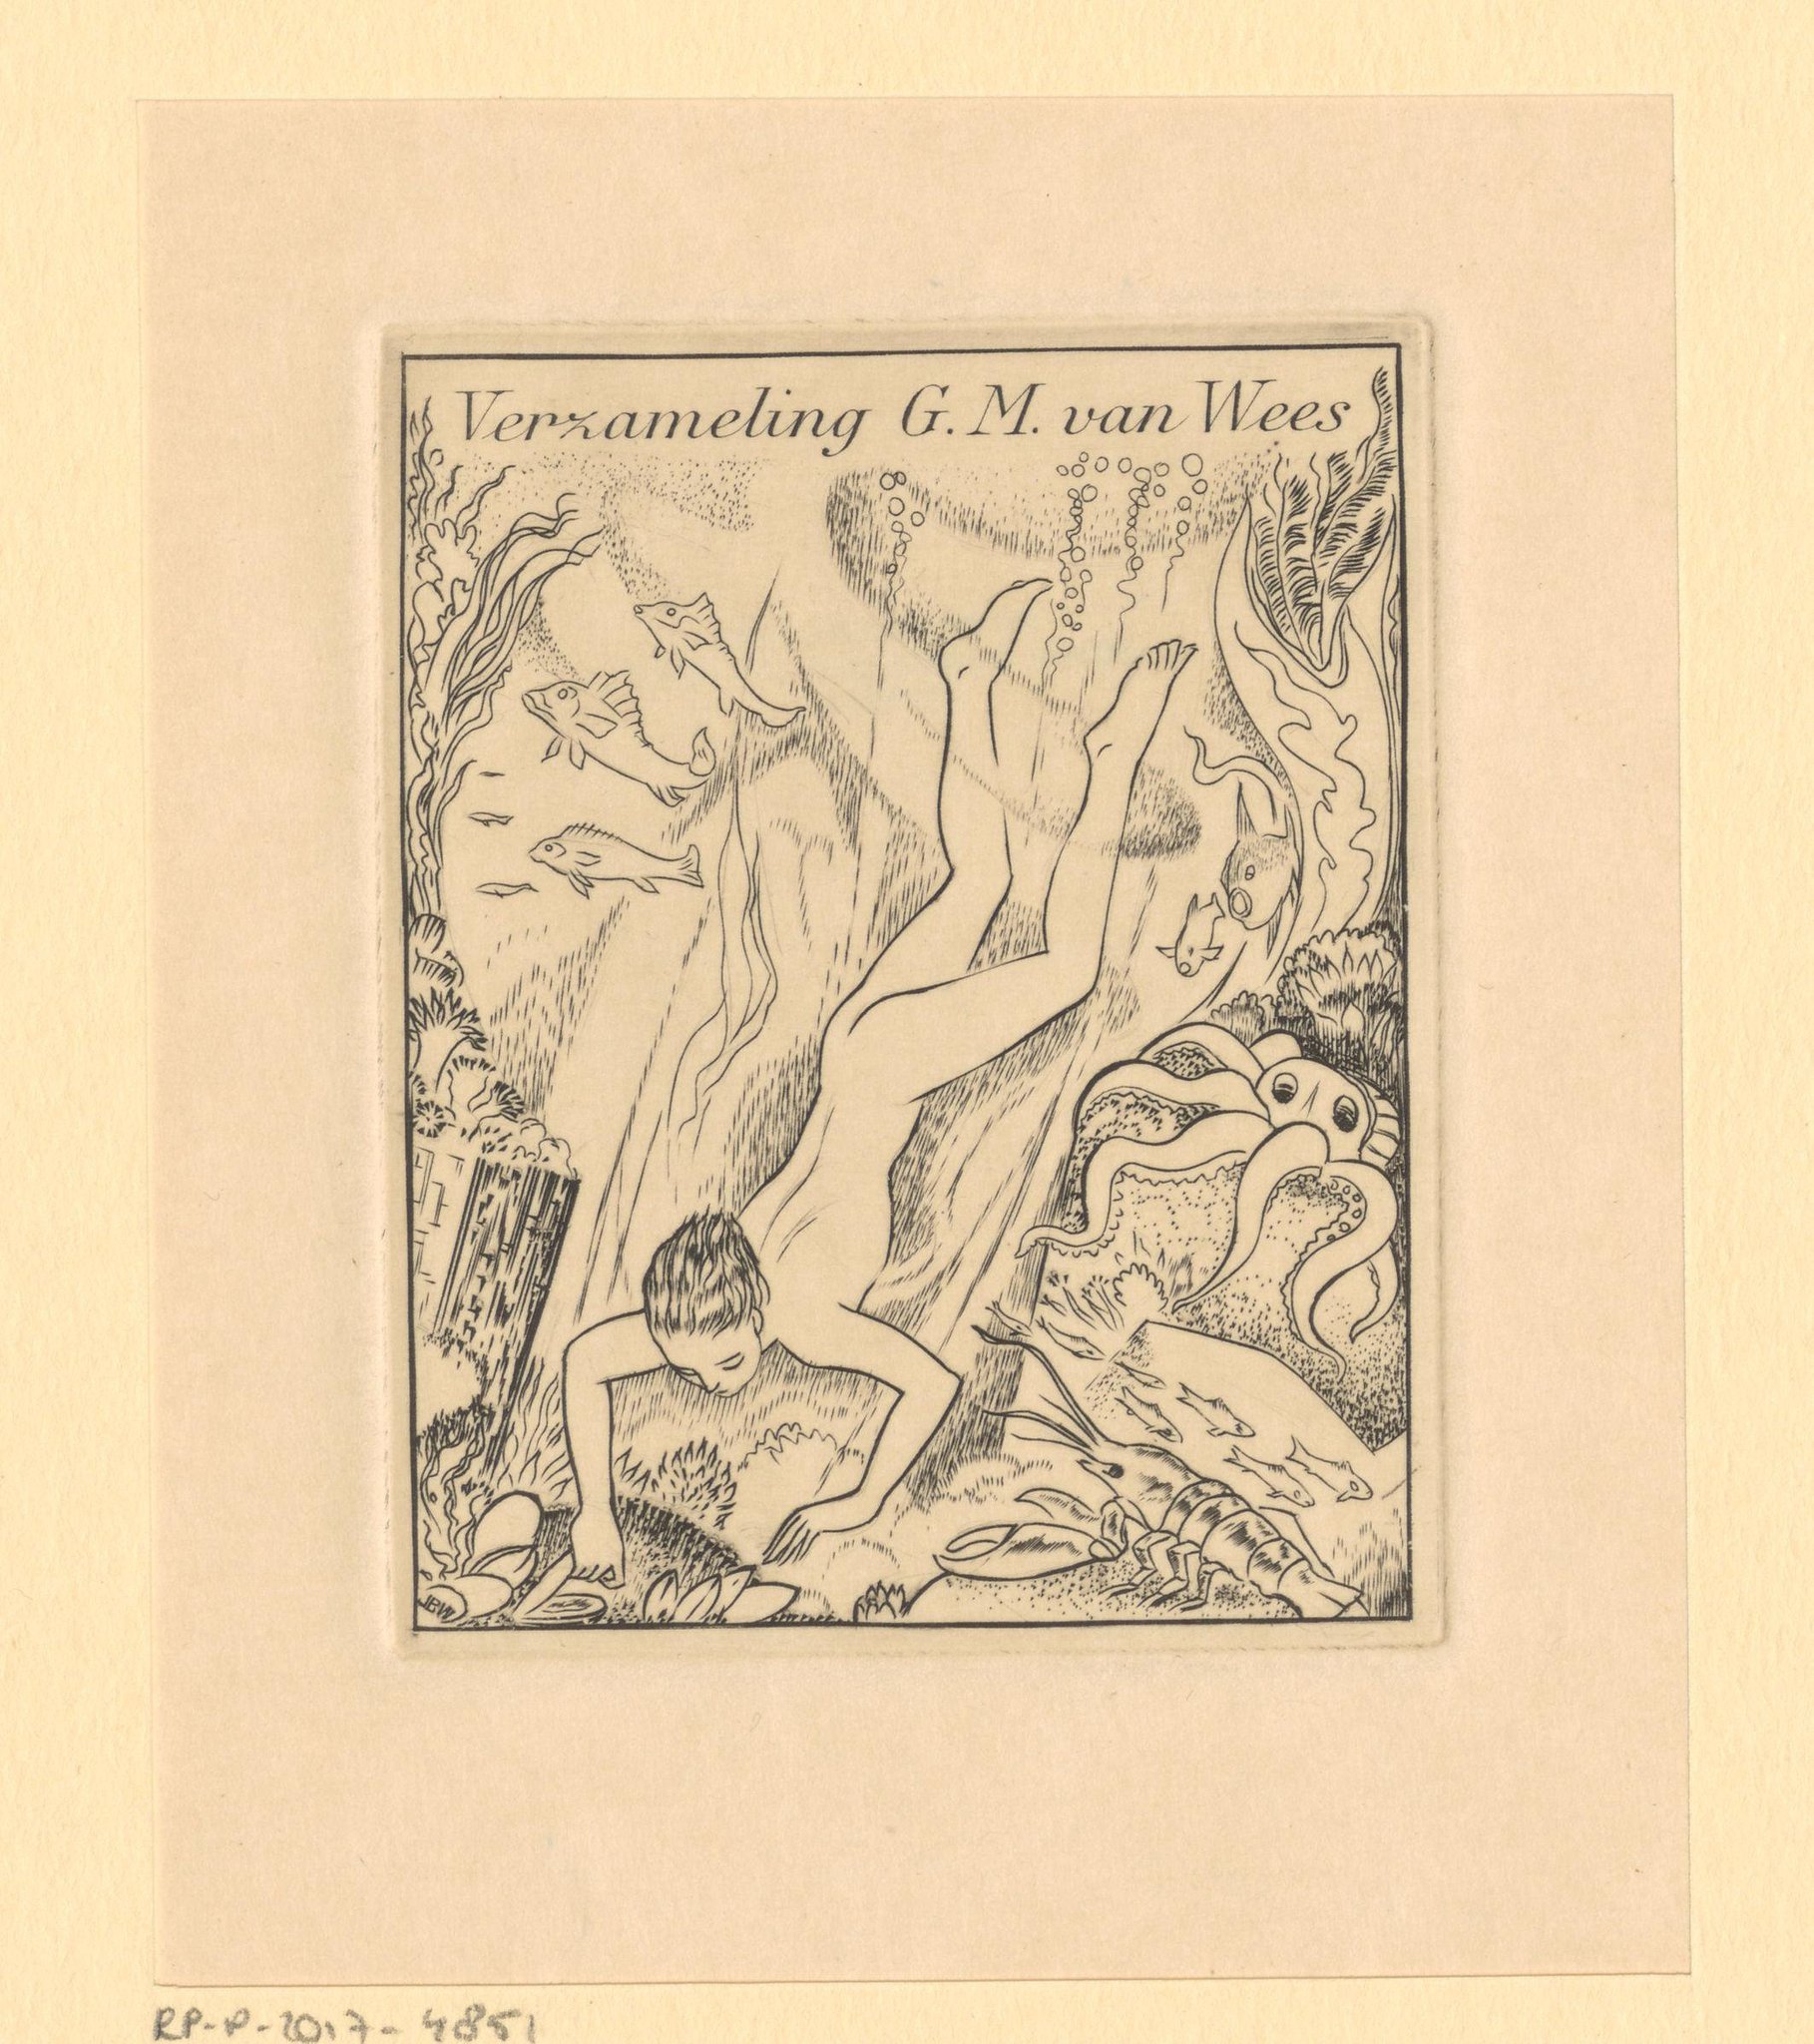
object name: bookplate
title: Ex libris van G.M. van Wees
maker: john buckland wright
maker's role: print maker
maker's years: 1897-1954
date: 1939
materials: paper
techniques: engraving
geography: england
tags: publisher, molluscs: octopus, diving (sport), fishes, woman (showing herself) undressed, quasi-nude, molluscs: oyster